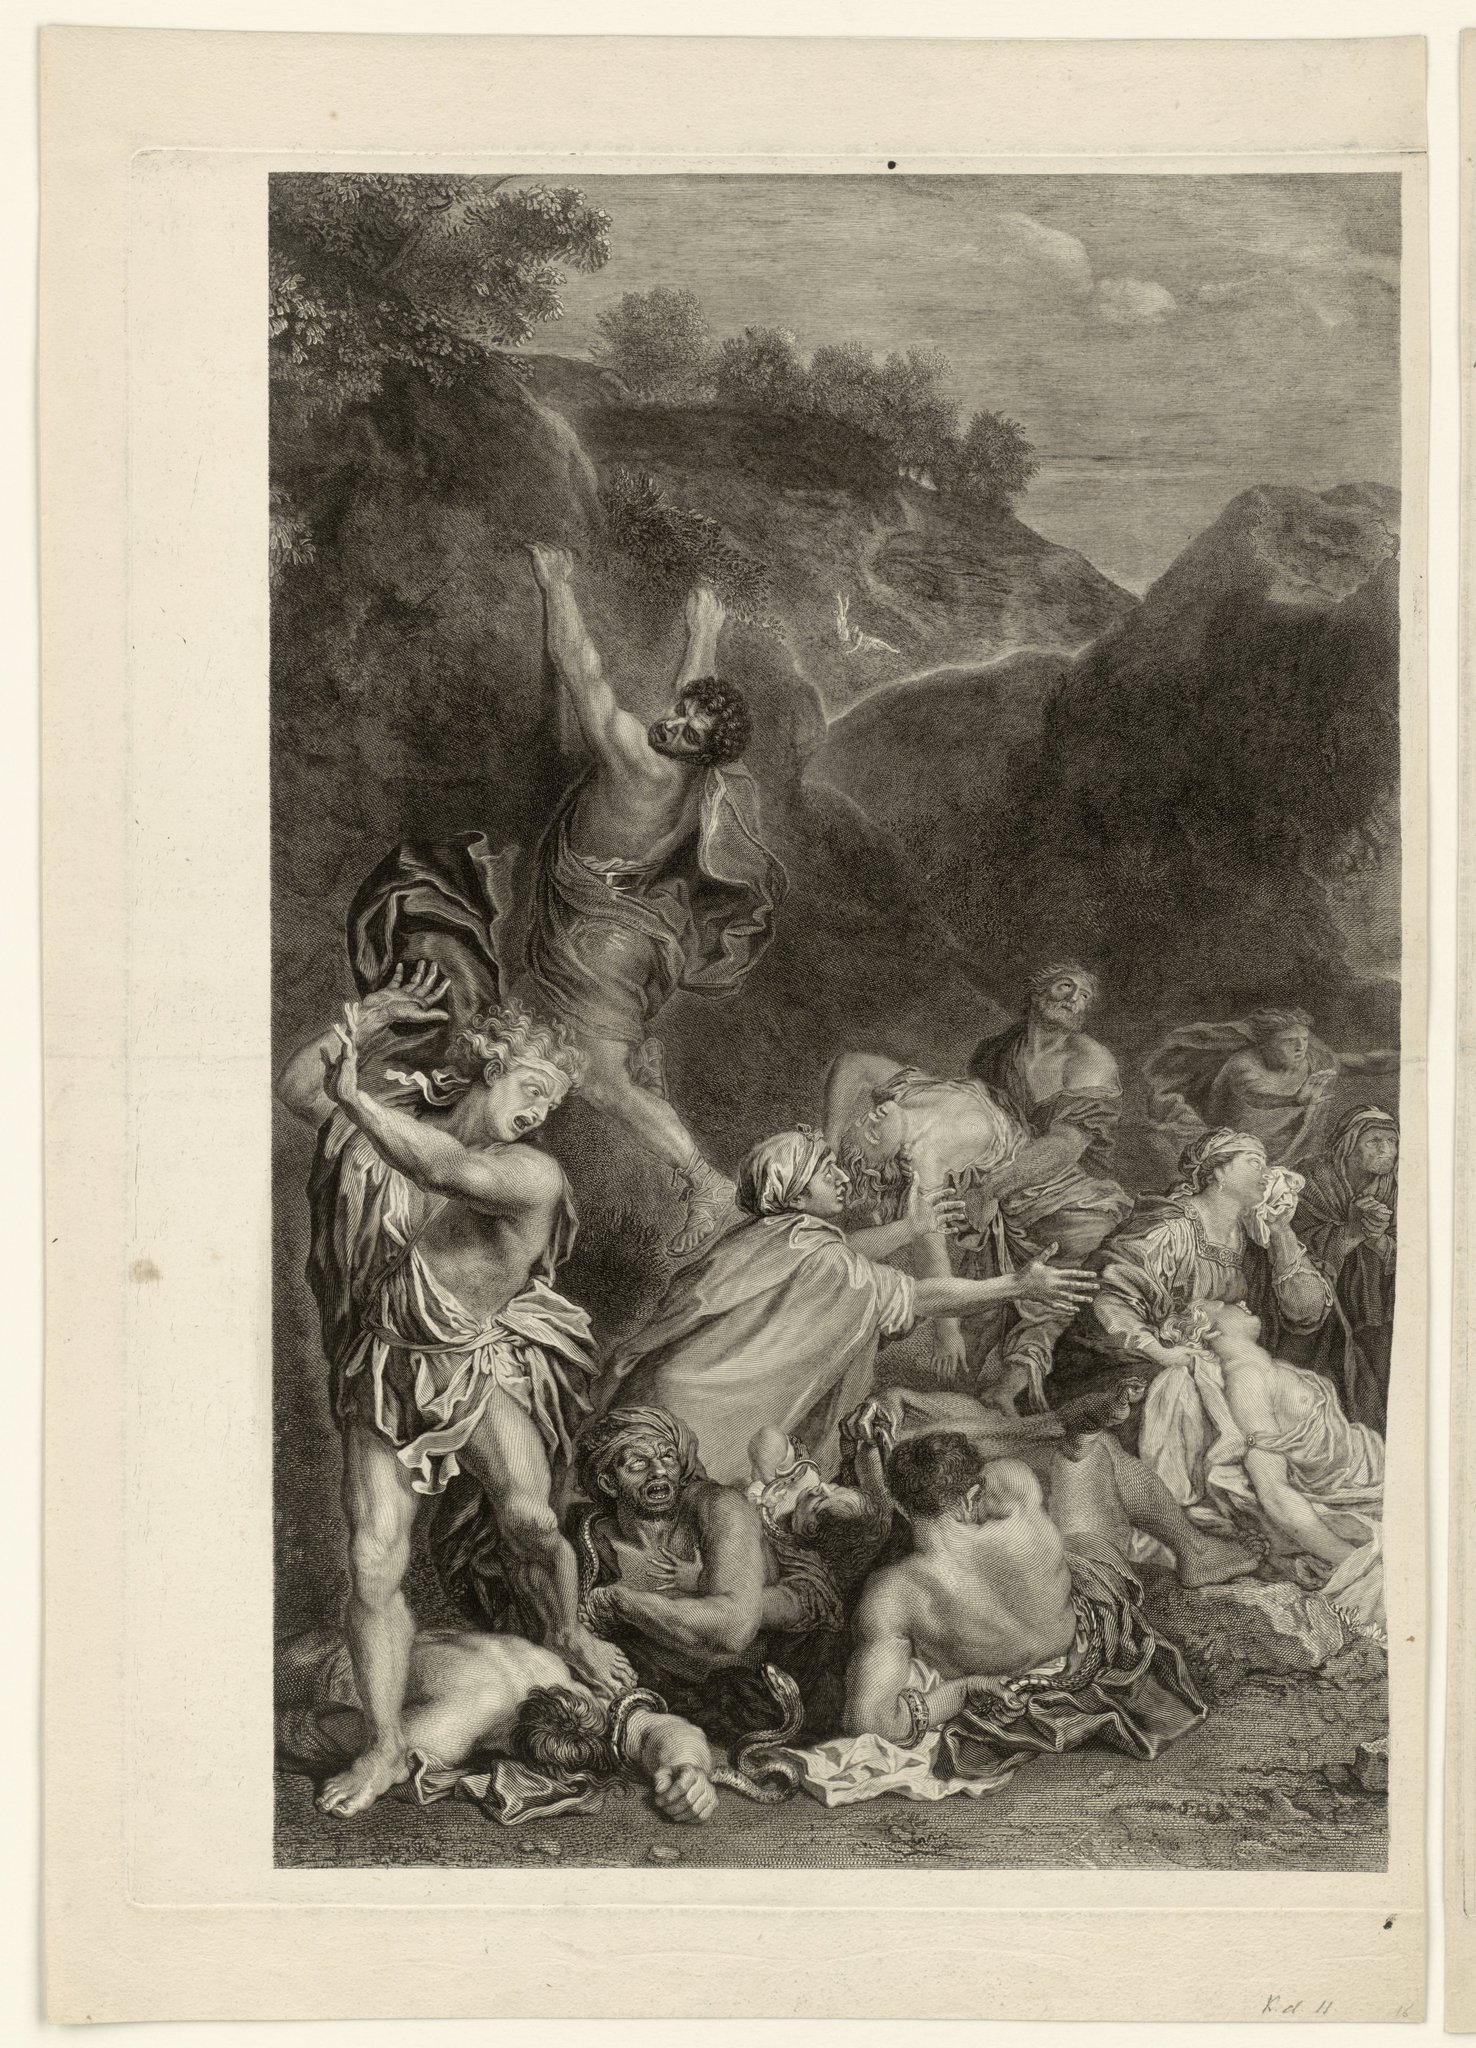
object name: print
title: De oprichting van de koperen slang (rechter helft)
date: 1646-1700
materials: paper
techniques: engraving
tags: the brazen serpent (numbers 21:4-9)